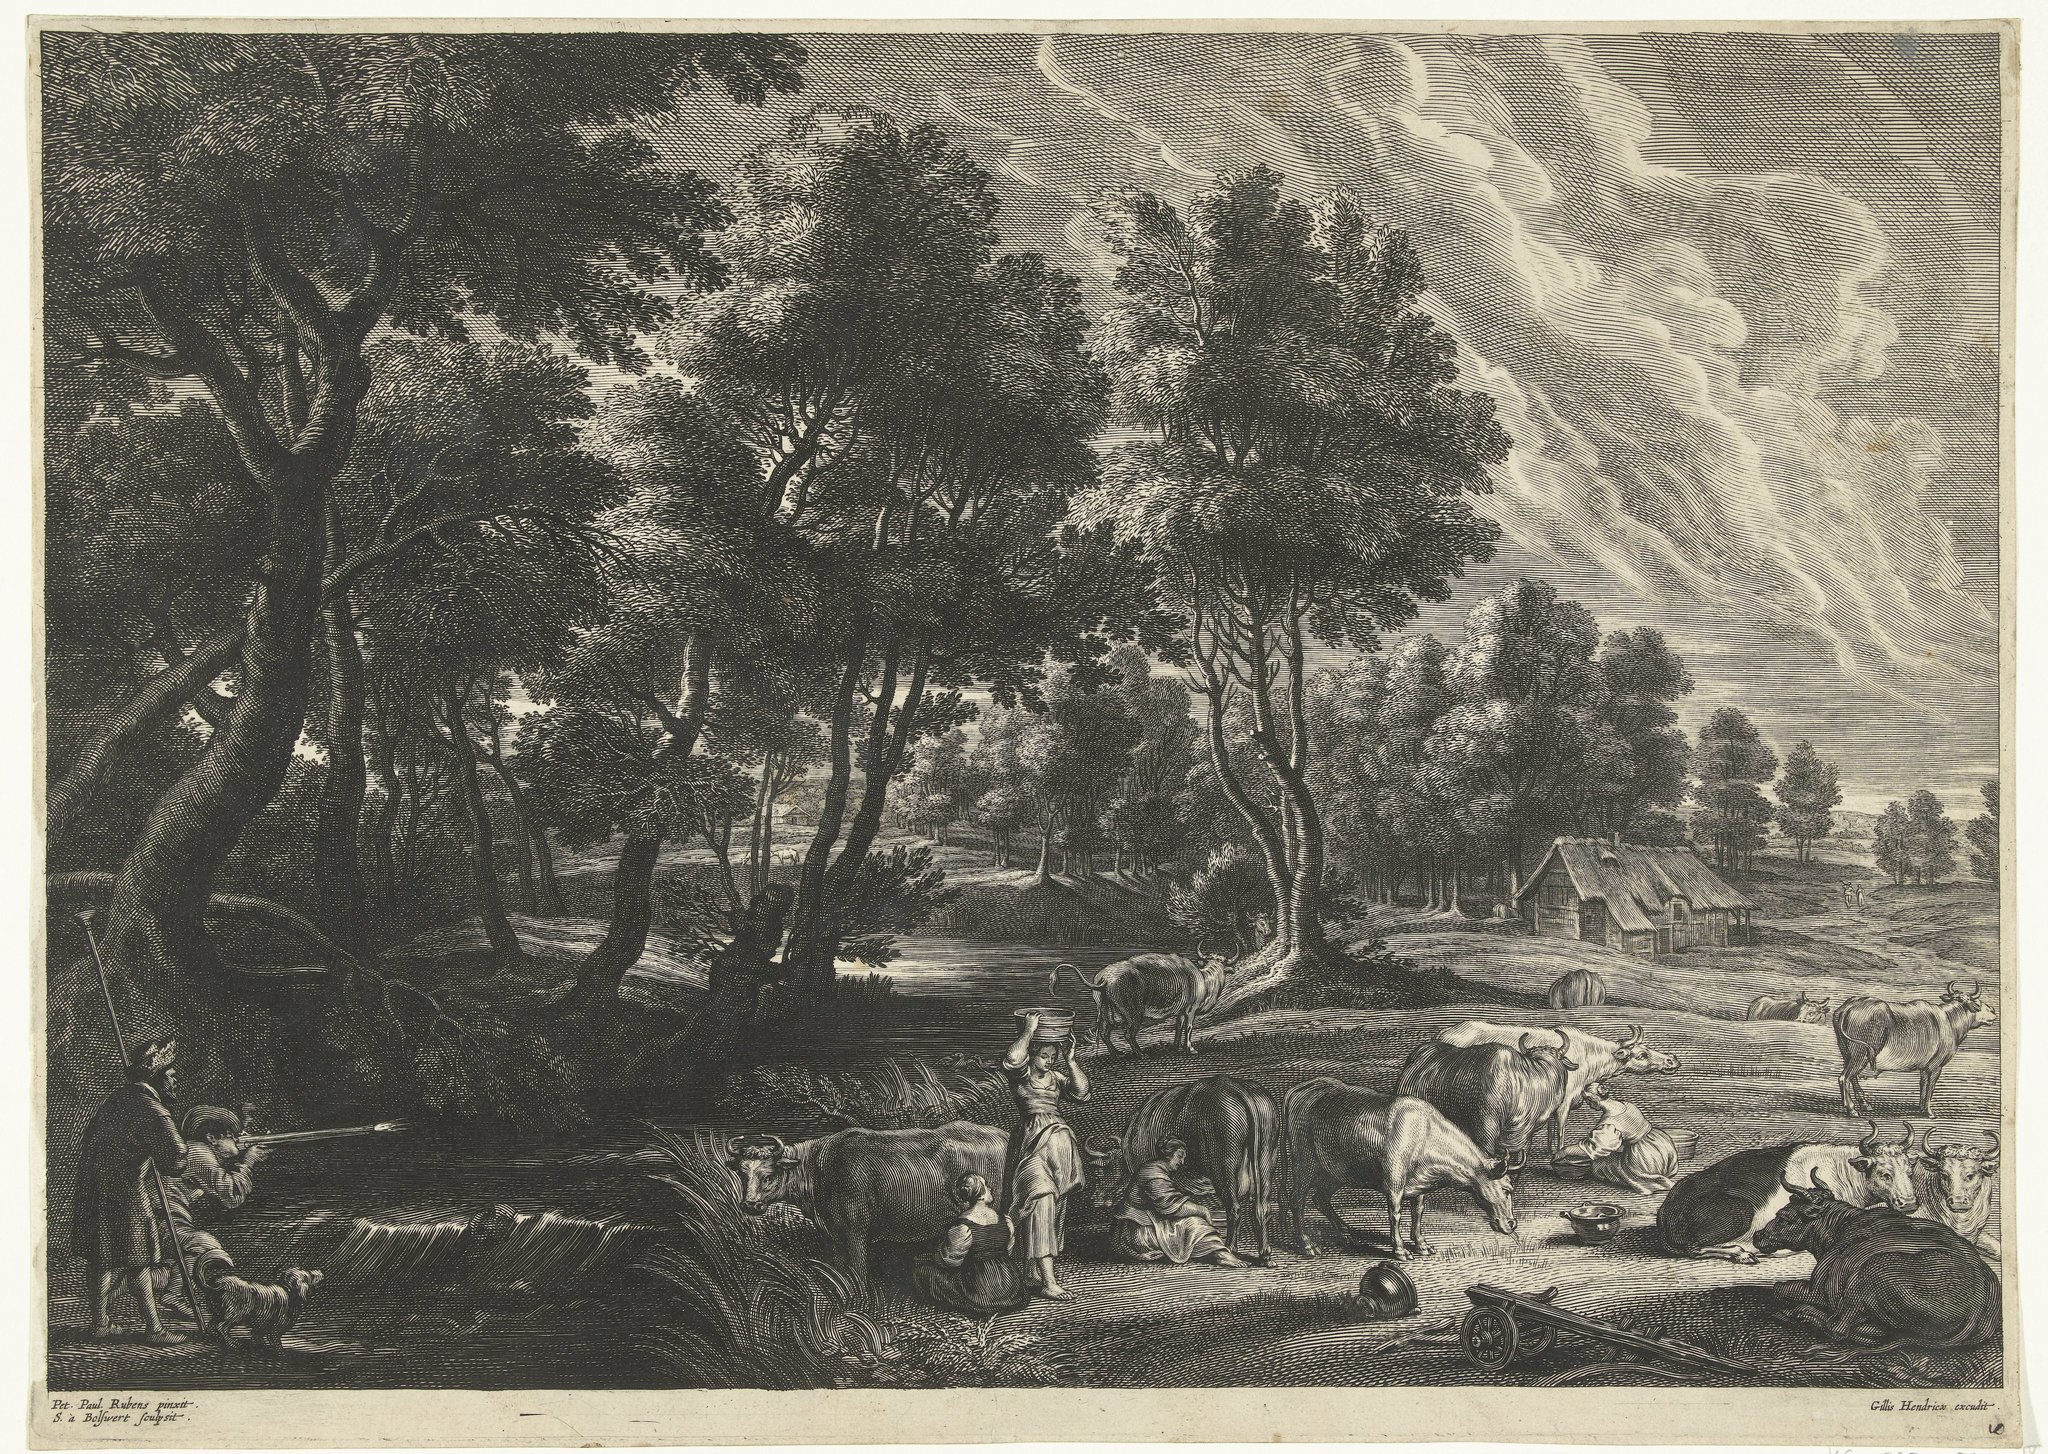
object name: print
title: Landschap met melkmeisjes en koeien en jagers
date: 1596-1659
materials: paper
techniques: engraving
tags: cow, hunter, milkmaid, milking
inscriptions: inscription: ‘B 29 39-58’, collector's mark: Lugt 10, collector's mark: Lugt 11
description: Prent naar schilderij van Peter Paul Rubens. Hollstein beschrijft een serie kleine landschappen onder de nrs. 305 t/m 325 maar deze prenten zijn niet als reeks vervaardigd.